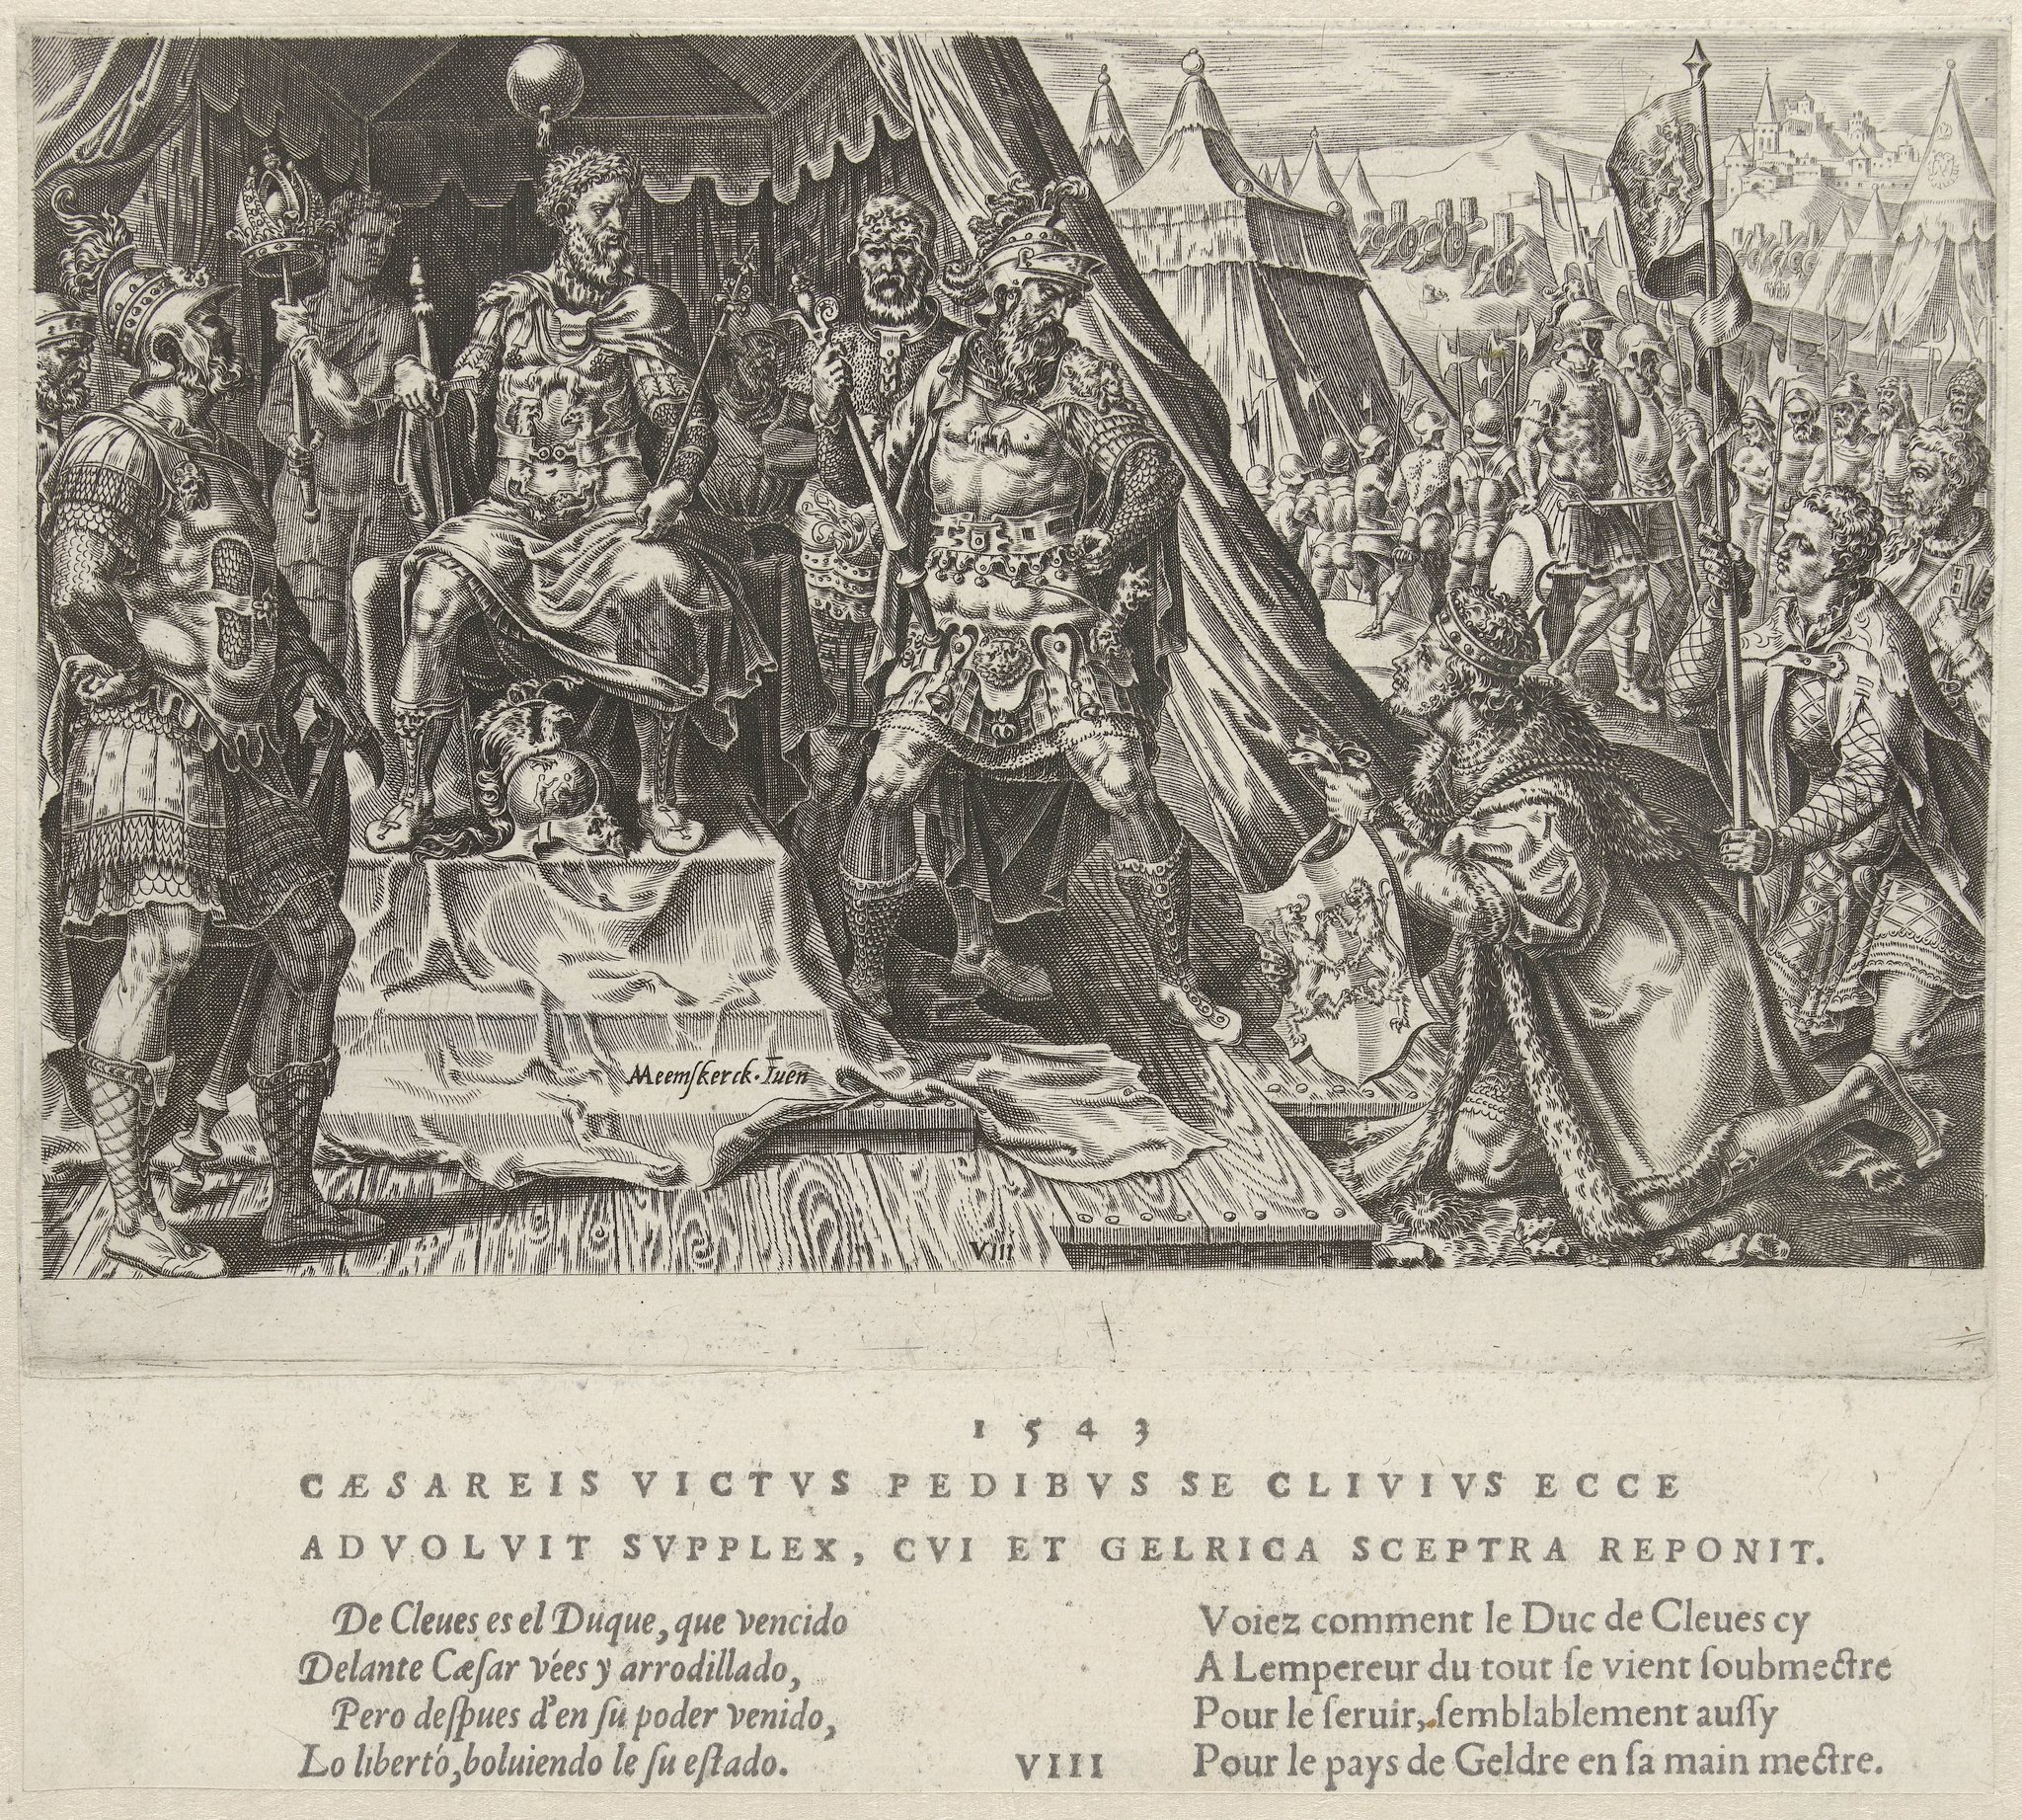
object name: print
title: Divi Caroli. V. imp. opt. max. victoriae, ex multis praecipuae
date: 1555-1556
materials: paper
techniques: engraving, etching, letterpress printing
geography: haarlem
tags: ghent, charles v (holy roman emperor and king of spain)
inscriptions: collector's mark: Lugt 2228, collector's mark: Lugt 2760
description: Tijdens de Vrede van Venlo (1543) knielt de hertog van Gelre, Willem II, voor de troon van keizer Karel V en onderwerpt zich aan zijn macht. Hij overhandigt hem het wapenschild van Gelre. De prent heeft een Latijns, Spaans en Frans onderschrift en maakt deel uit van een twaalfdelige serie over de overwinningen van Karel V.